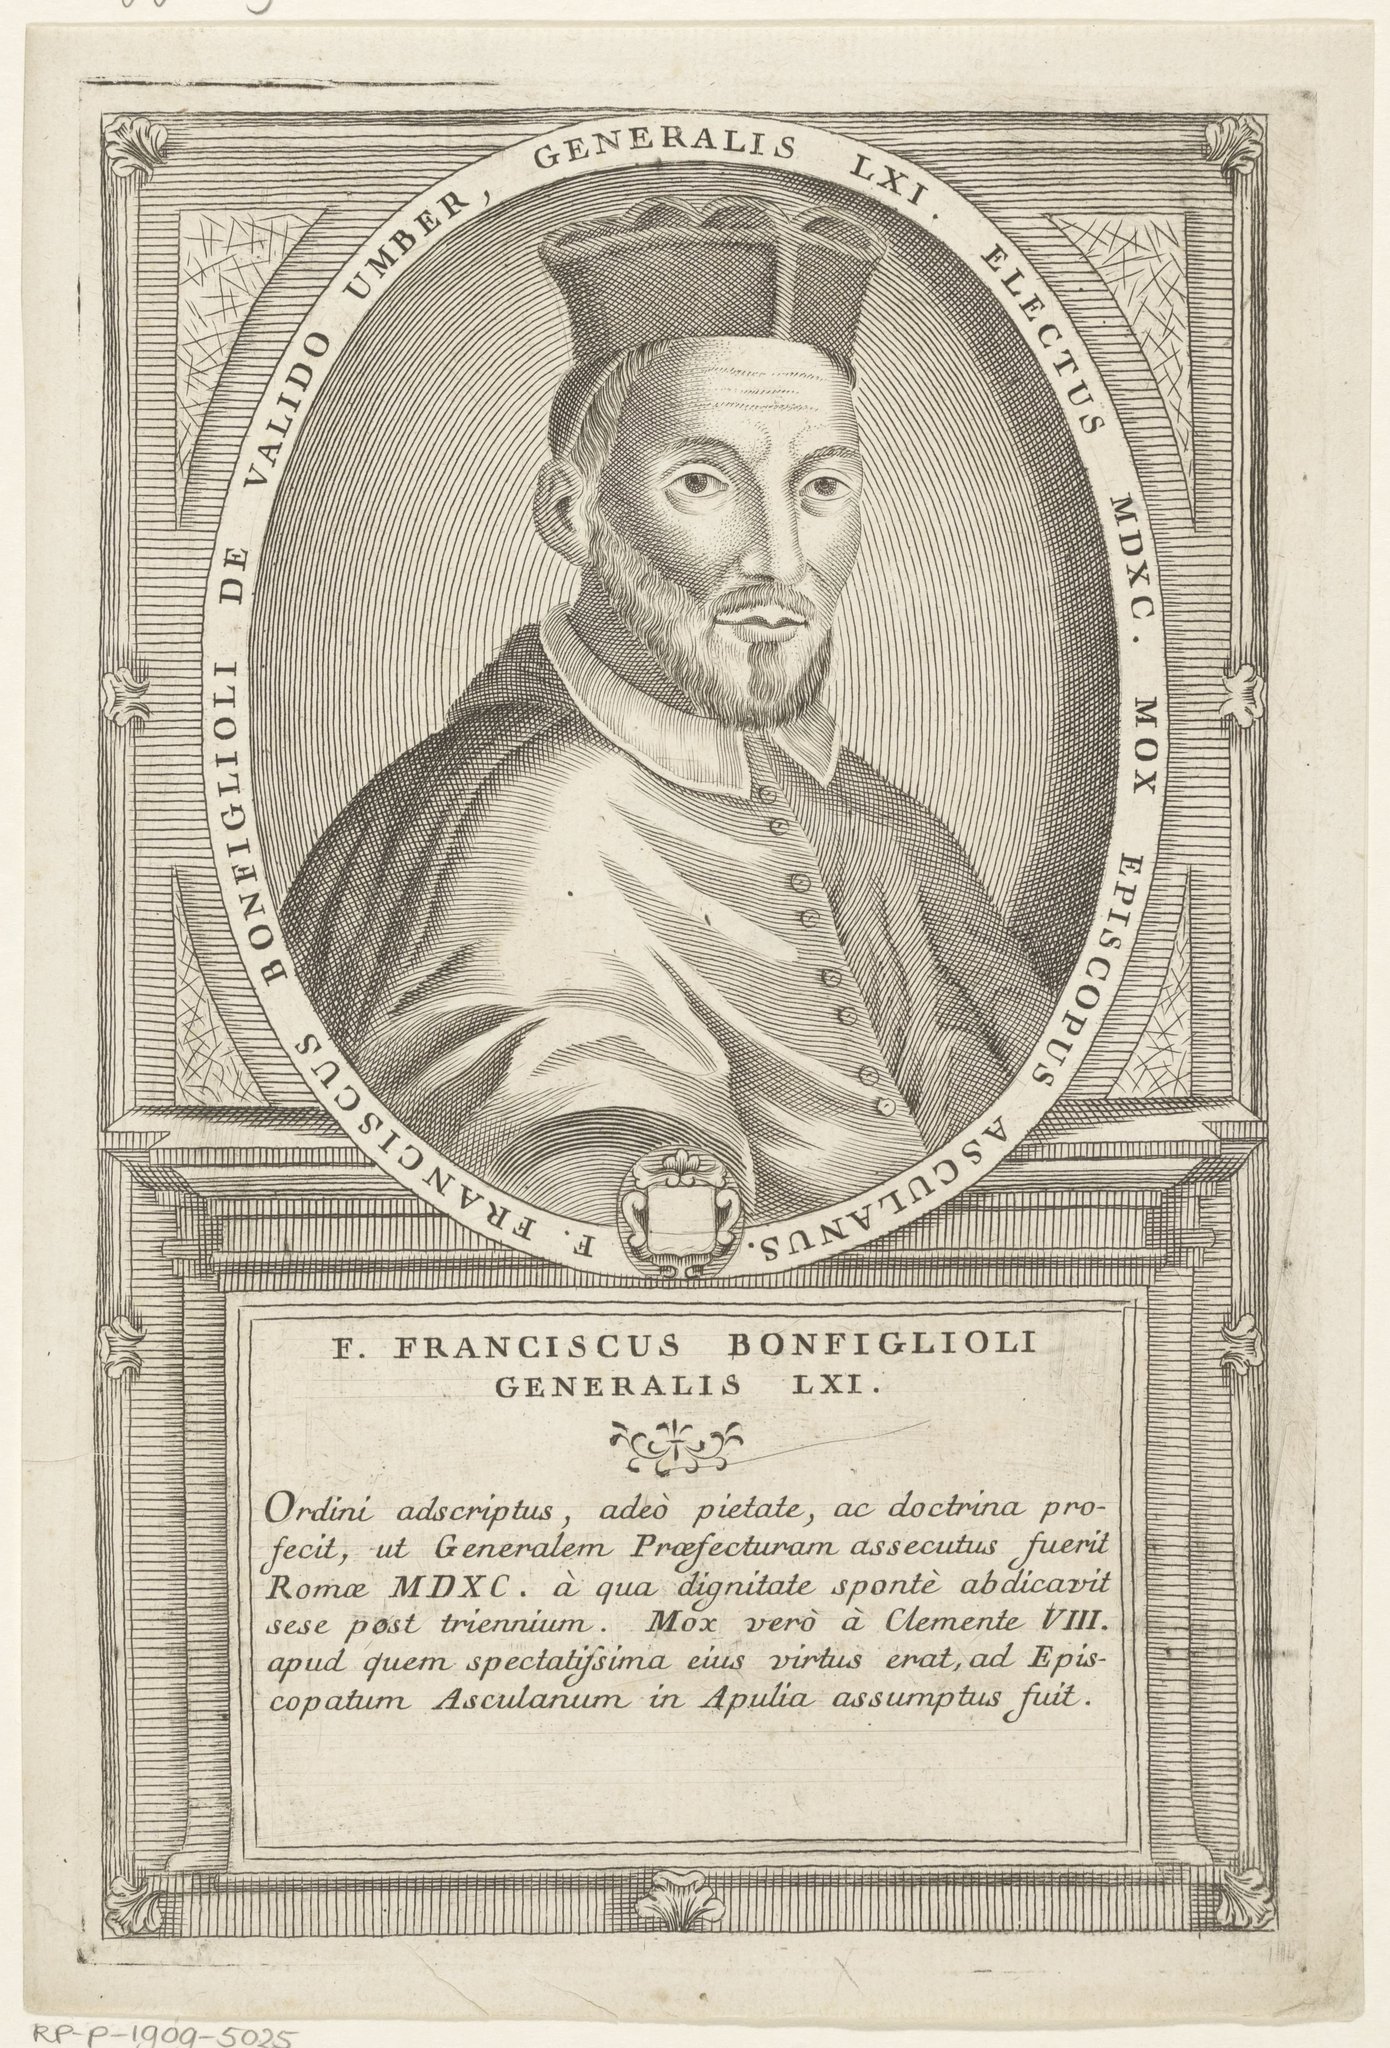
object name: print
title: Portret van Francisco Bonfigli, 61ste Minister Generaal van de franciscaner orde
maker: antonio luciani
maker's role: print maker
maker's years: 1700-1738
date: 1710-1738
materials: paper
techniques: engraving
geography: italy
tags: clergyman, historical persons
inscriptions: collector's mark: Lugt 2228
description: Deze prent maakt deel uit van een groep van 60 portretten.